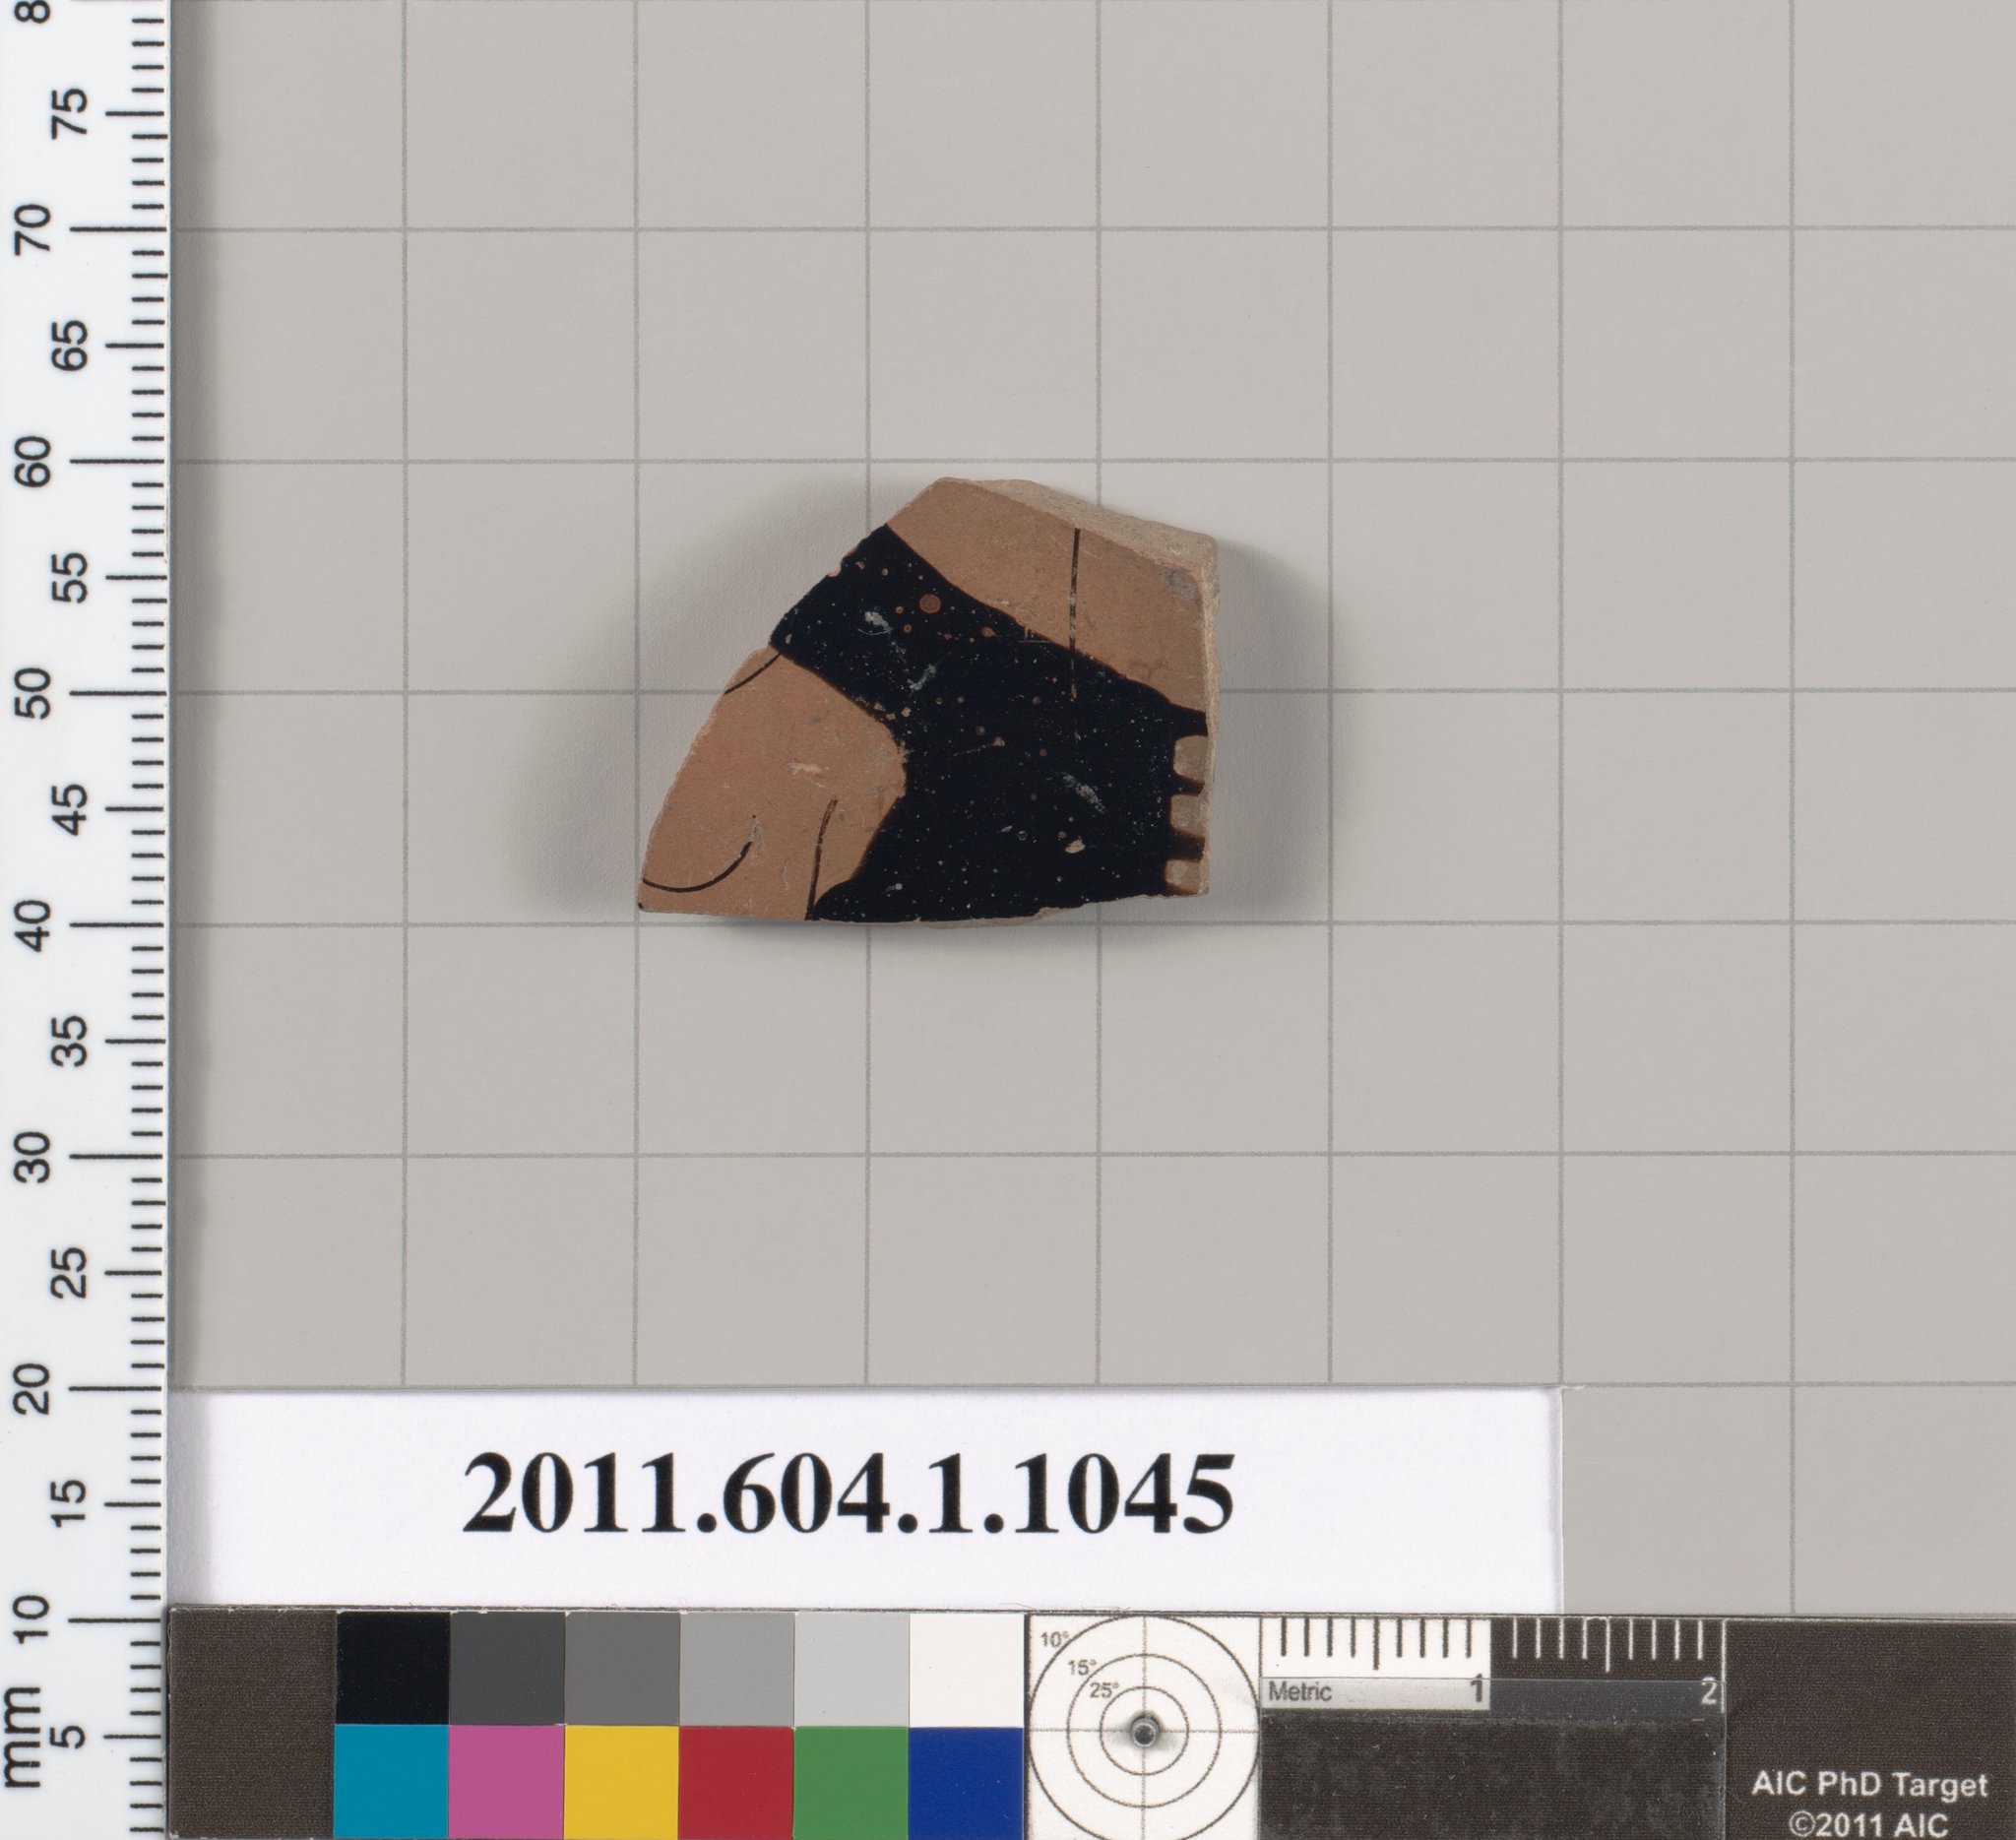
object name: kylix fragment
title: Terracotta fragment of a kylix (drinking cup)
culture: greek, attic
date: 475-451 BCE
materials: terracotta